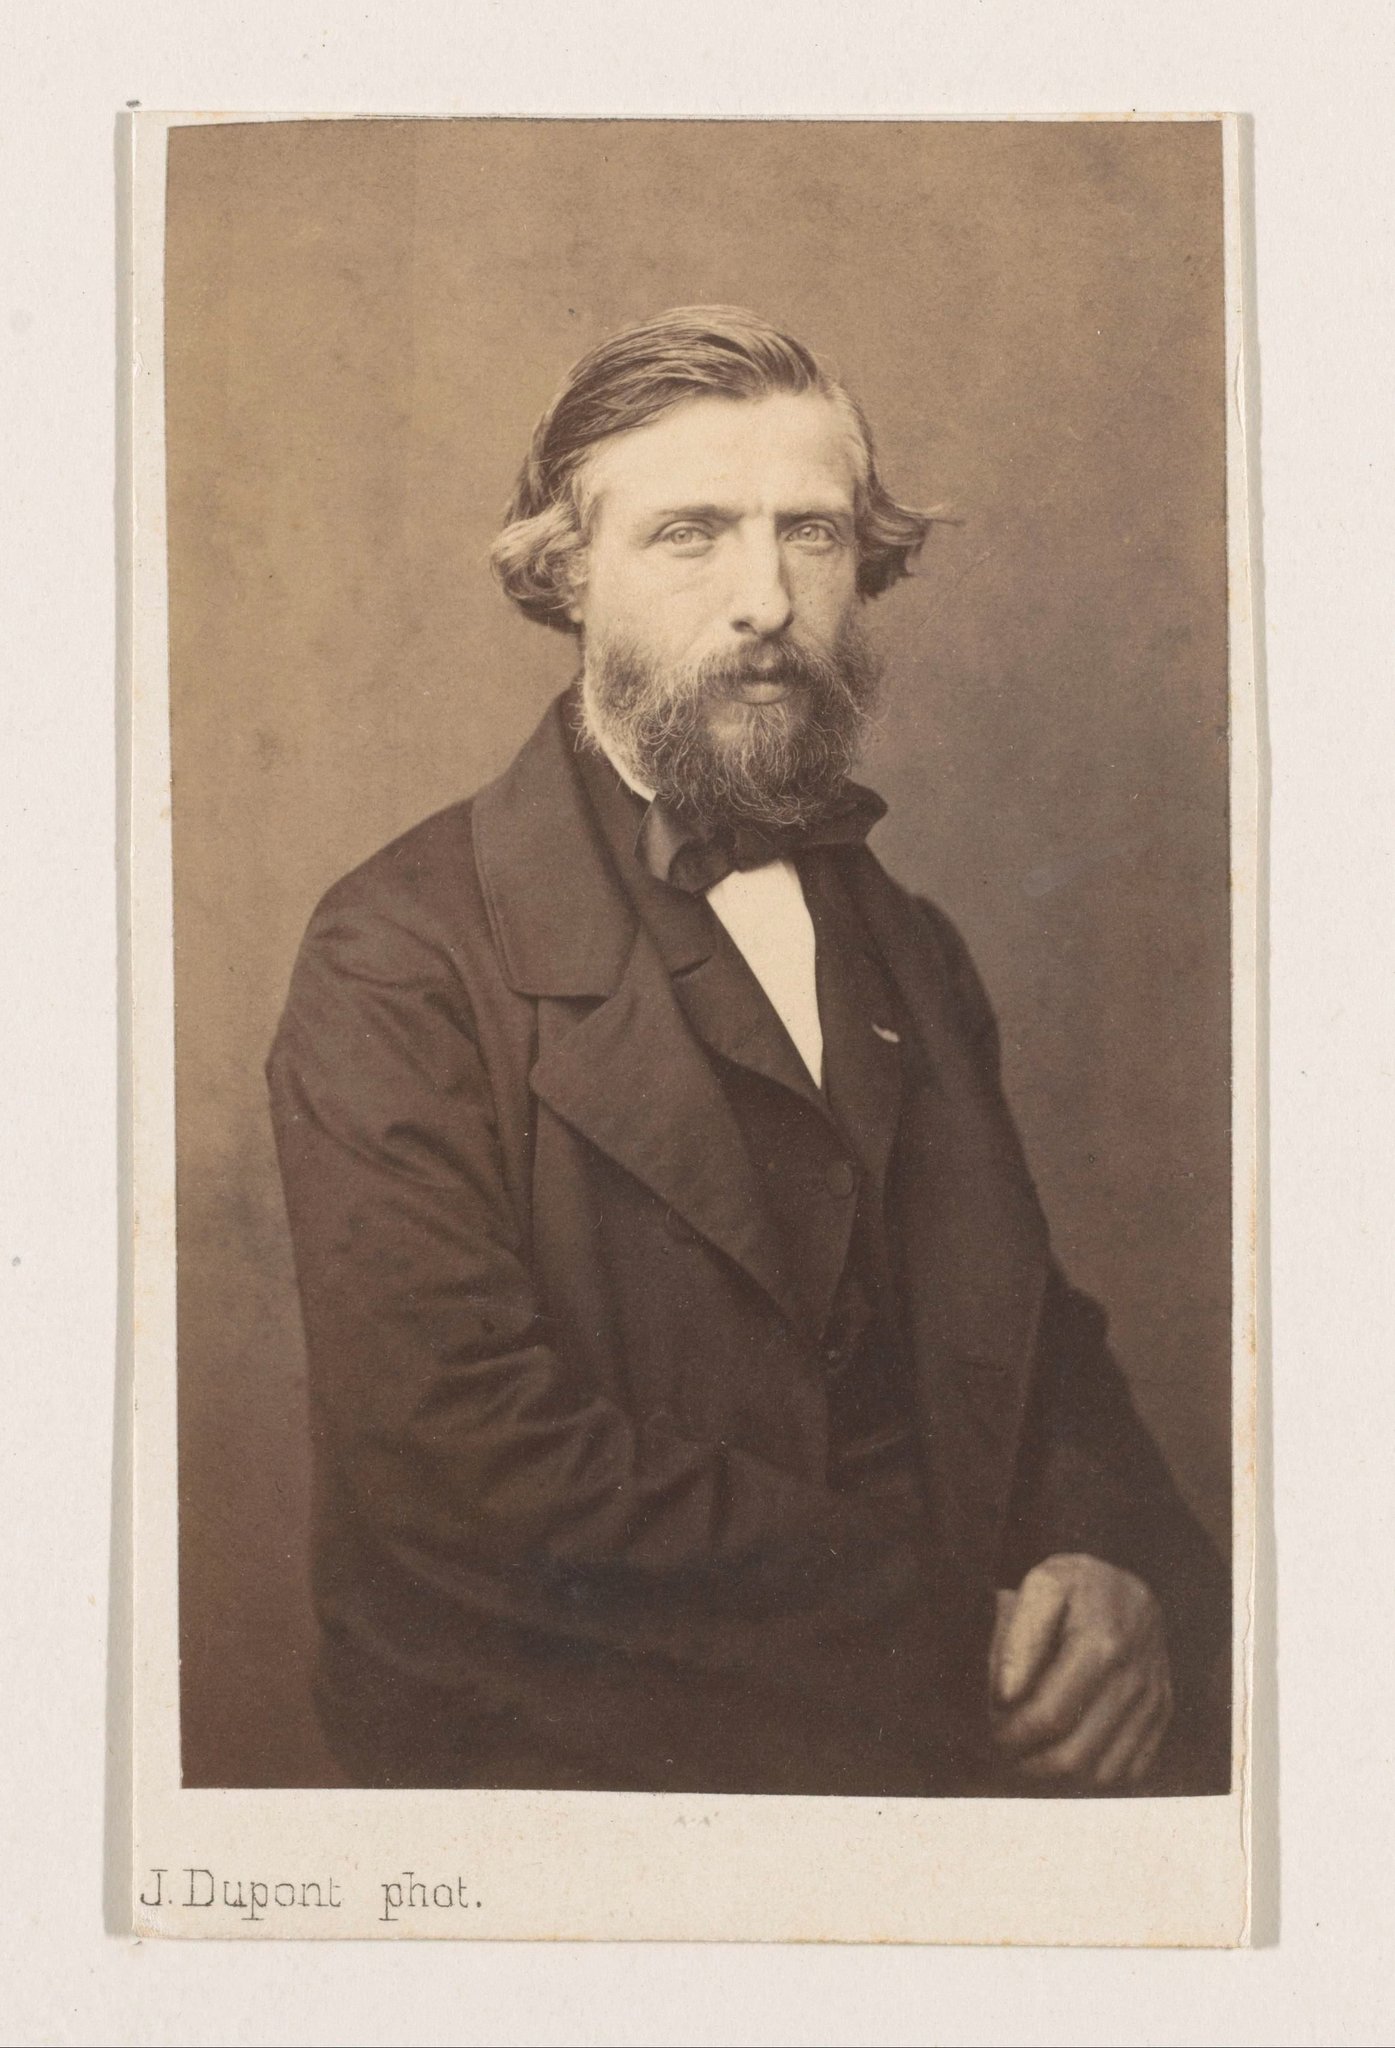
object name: carte de visite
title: Portret van de schilder Joseph-Laurens Dijckmans, halffiguur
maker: joseph dupont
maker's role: fotograaf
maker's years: 1818-1901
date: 1861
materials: cardboard, paper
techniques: albumen print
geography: antwerp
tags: lierre, antwerp, painter, joseph-laurens dijckmans, historical persons, portrait, self-portrait of painter, portrait, self-portrait of artist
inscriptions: inscription: ‘ETABLISSEMENT PHOTOGRAPHIQUE/ de/ J. DUPONT/ Place de Meir 32/ ANVERS/ Maison fondée en 1853’